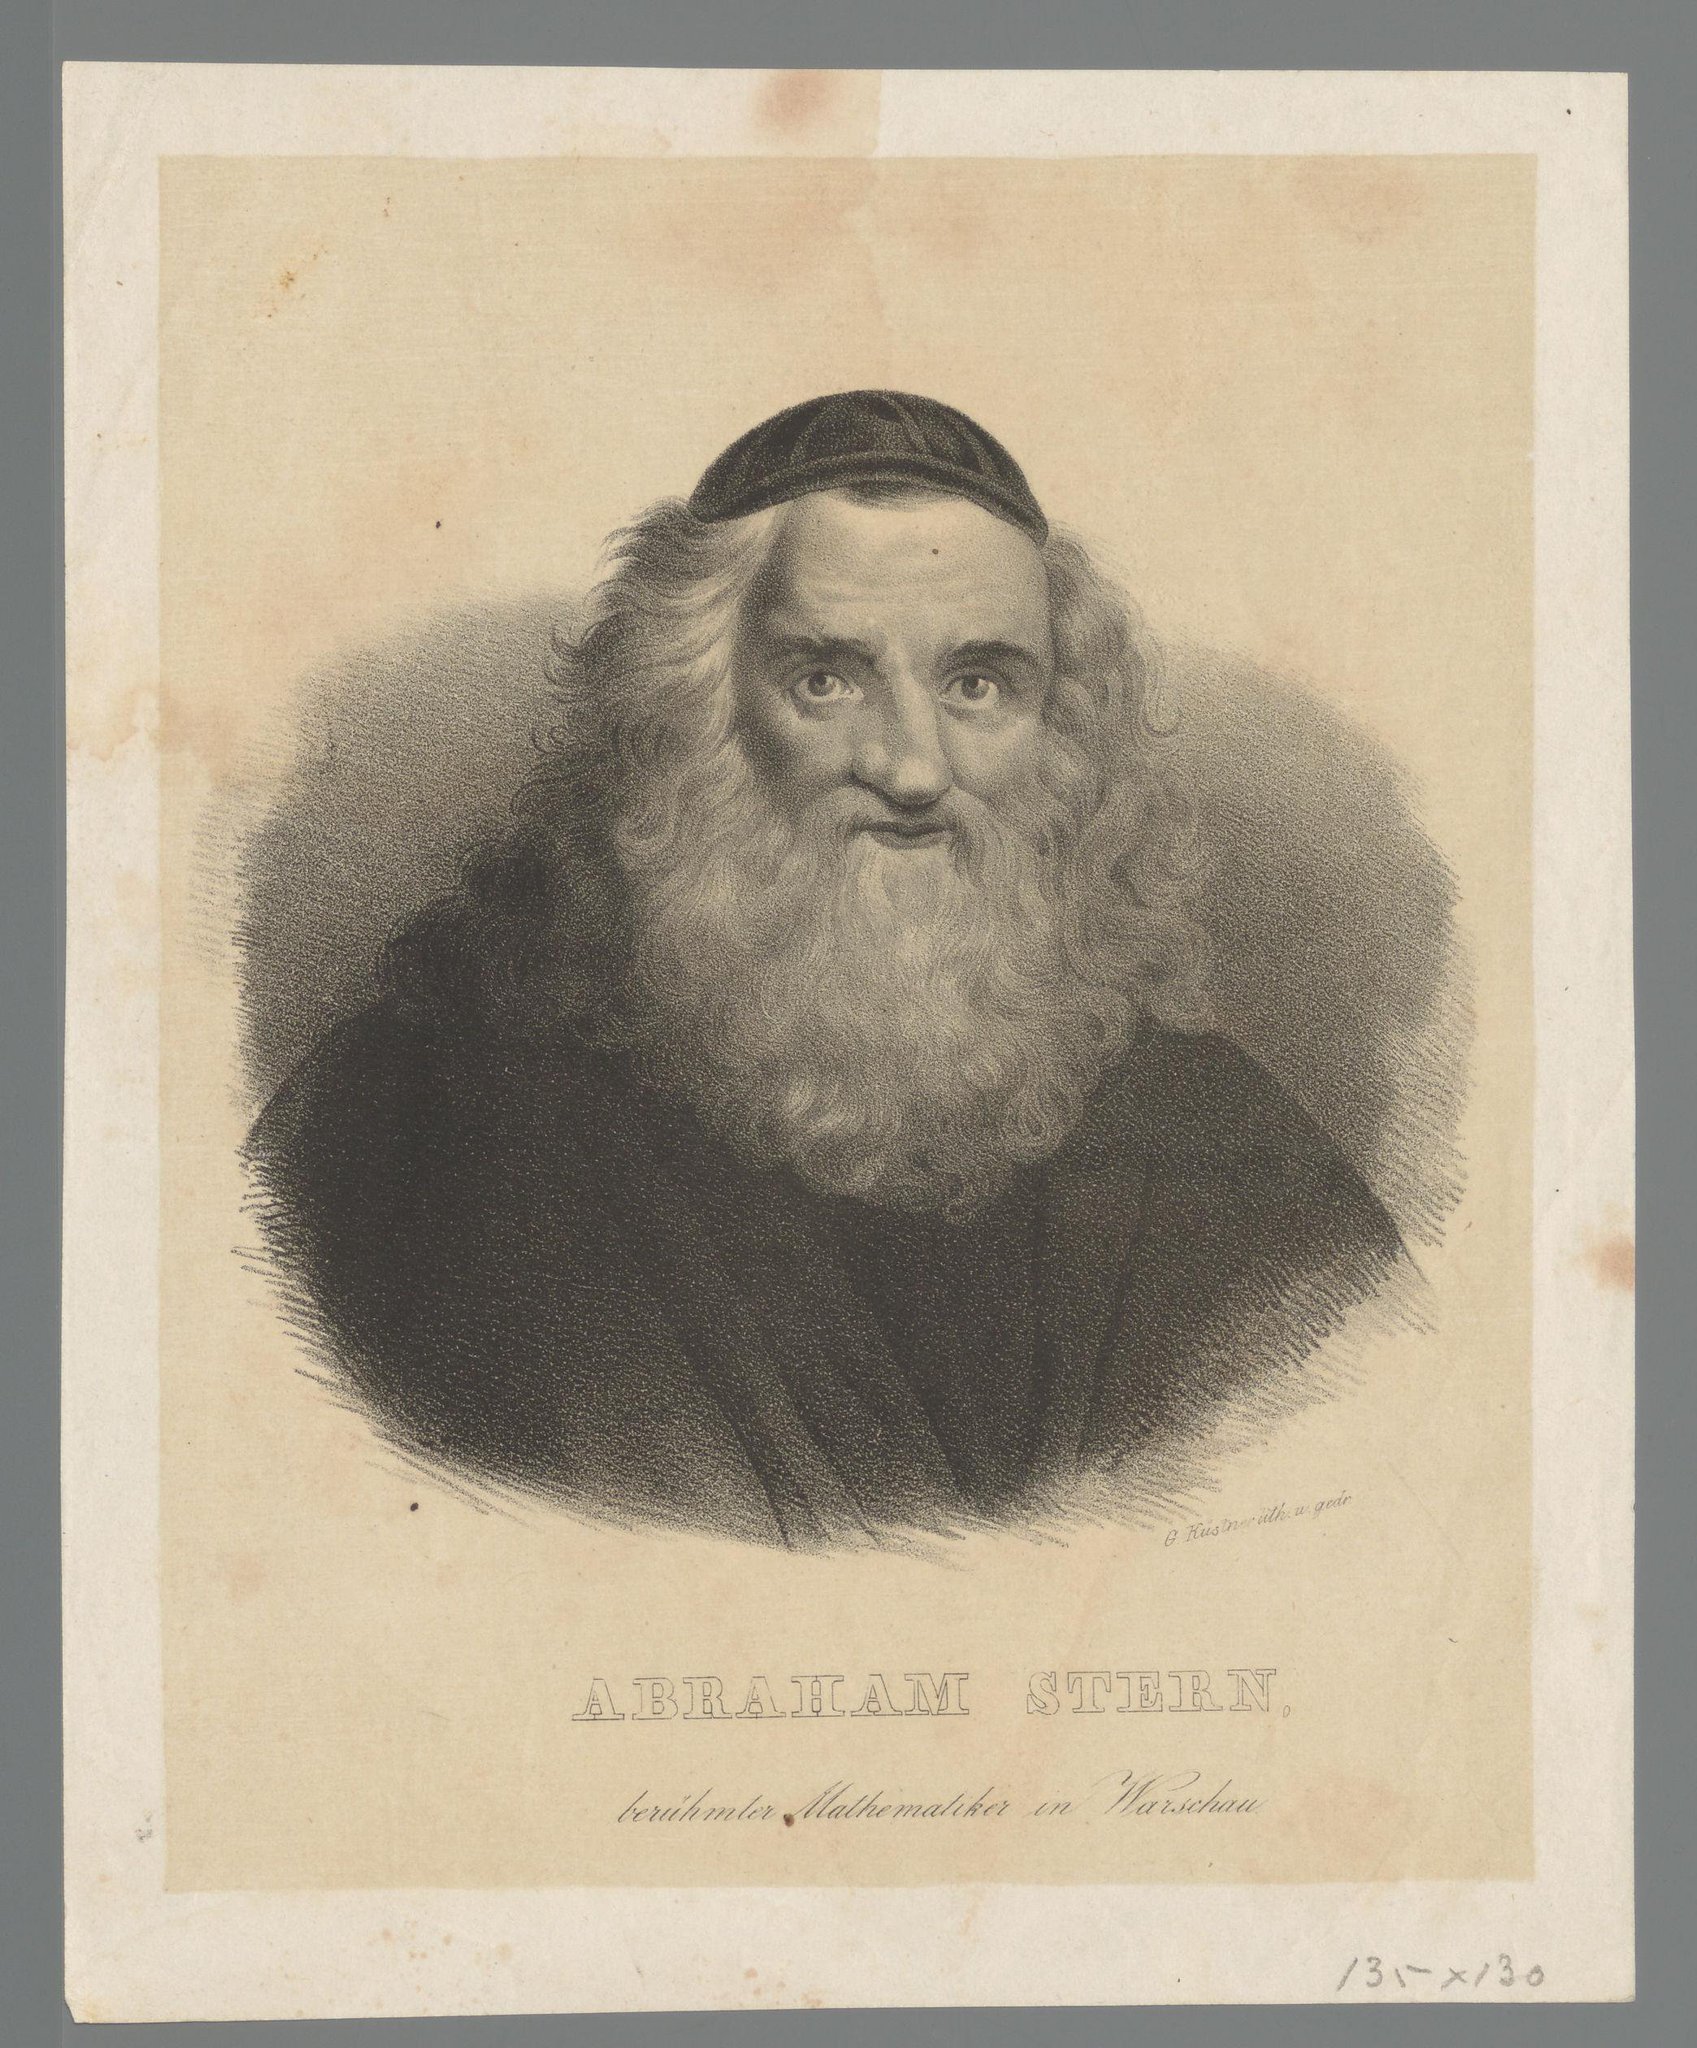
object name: print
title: Abraham Stern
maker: gottfried küstner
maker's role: print maker, printer, publisher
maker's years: 1800-1864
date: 1810-1864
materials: paper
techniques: tone lithography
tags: historical persons, mathematics (+ portrait of scholar, scientist)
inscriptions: collector's mark: Lugt 2228